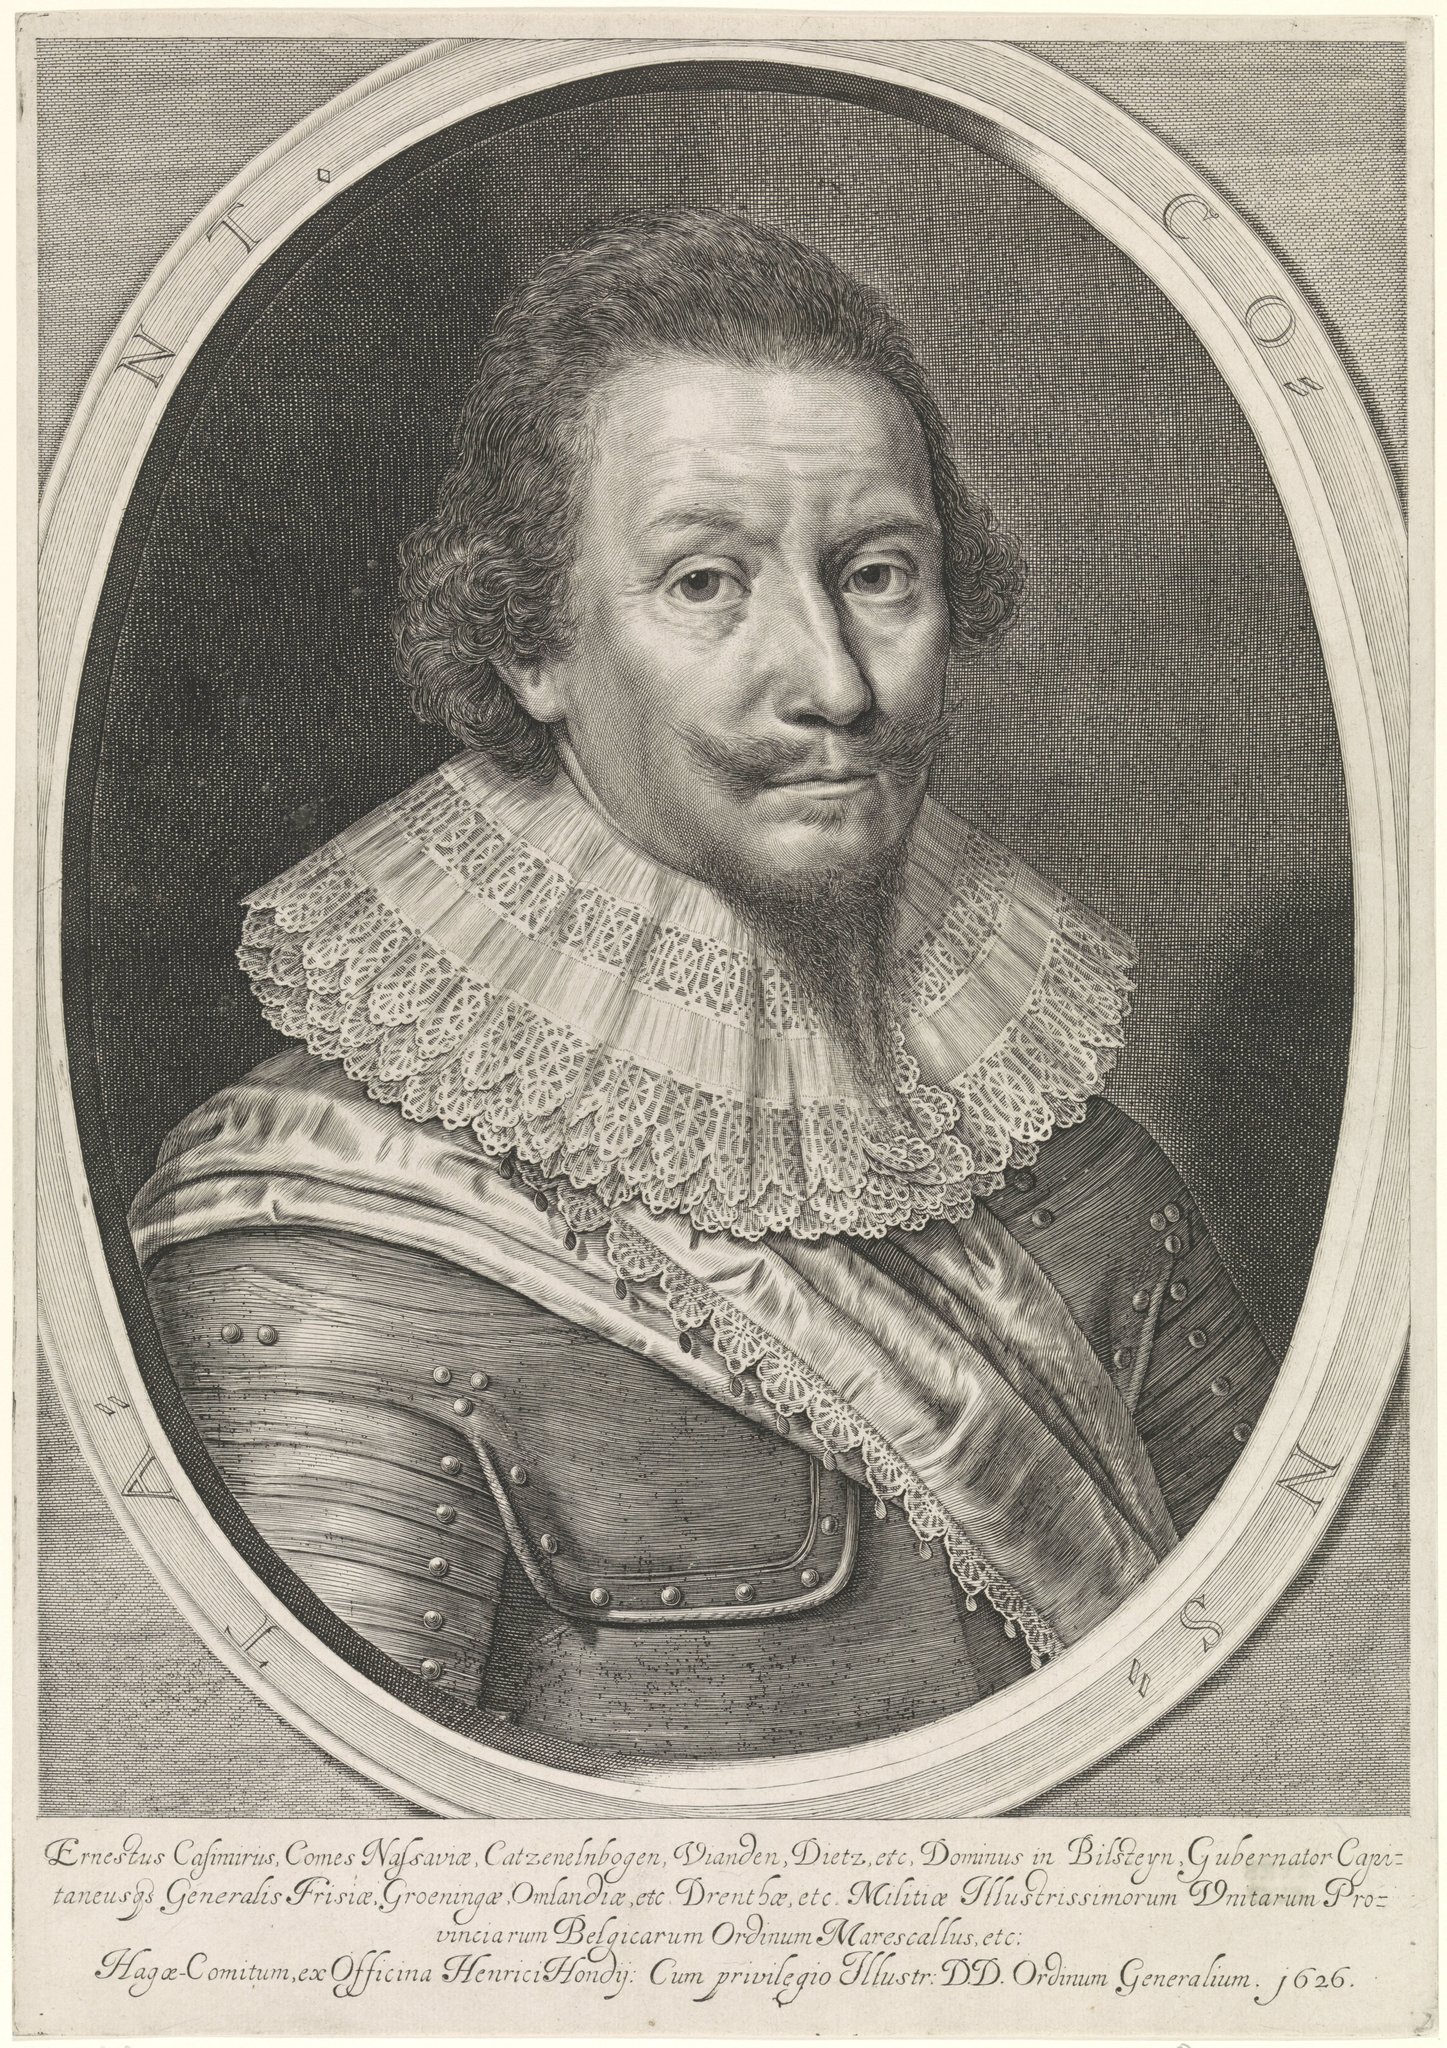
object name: print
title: Portret van Ernst Casimir, graaf van Nassau-Dietz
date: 1626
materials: paper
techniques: engraving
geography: the hague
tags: ernst casimir graaf van nassau-dietz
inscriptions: collector's mark: Lugt 2165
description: Buste naar rechts van Ernst Casimir, graaf van Nassau-Dietz in een ovale omlijsting met randschrift in het Latijn. Onder het portret drie regels in het Latijn.